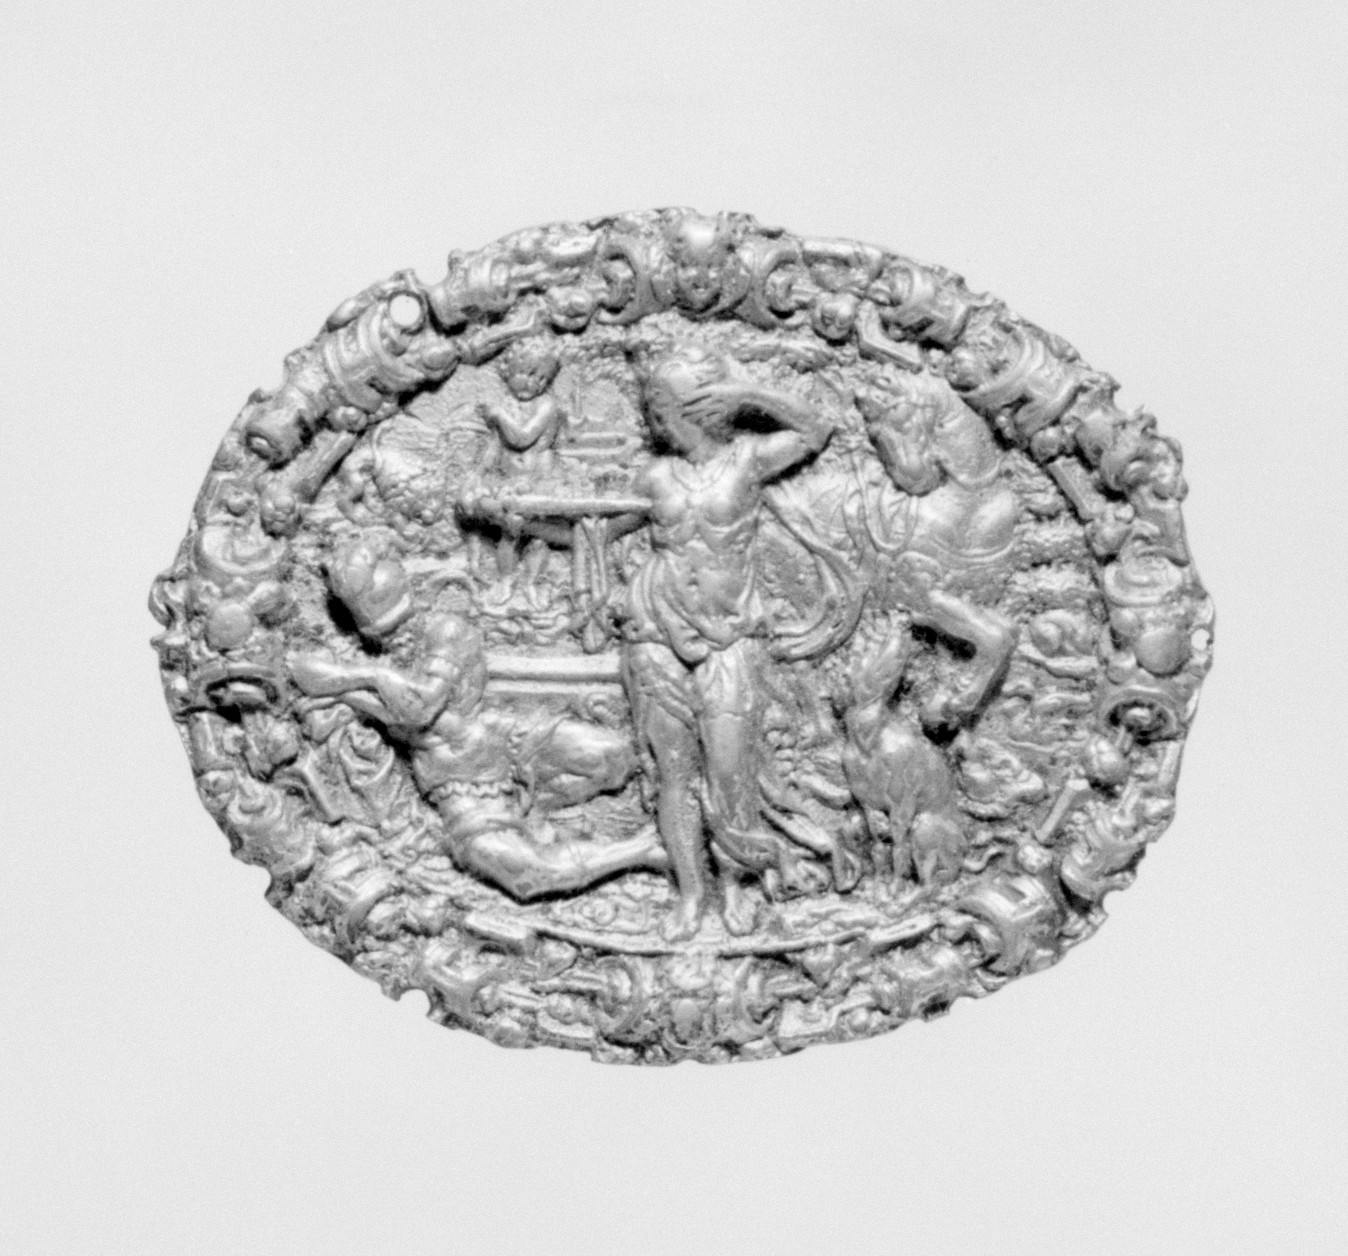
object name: plaquette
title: Pyramis and Thisbe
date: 1501-1600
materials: gilt bronze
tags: men,lovers,women,dogs,horses